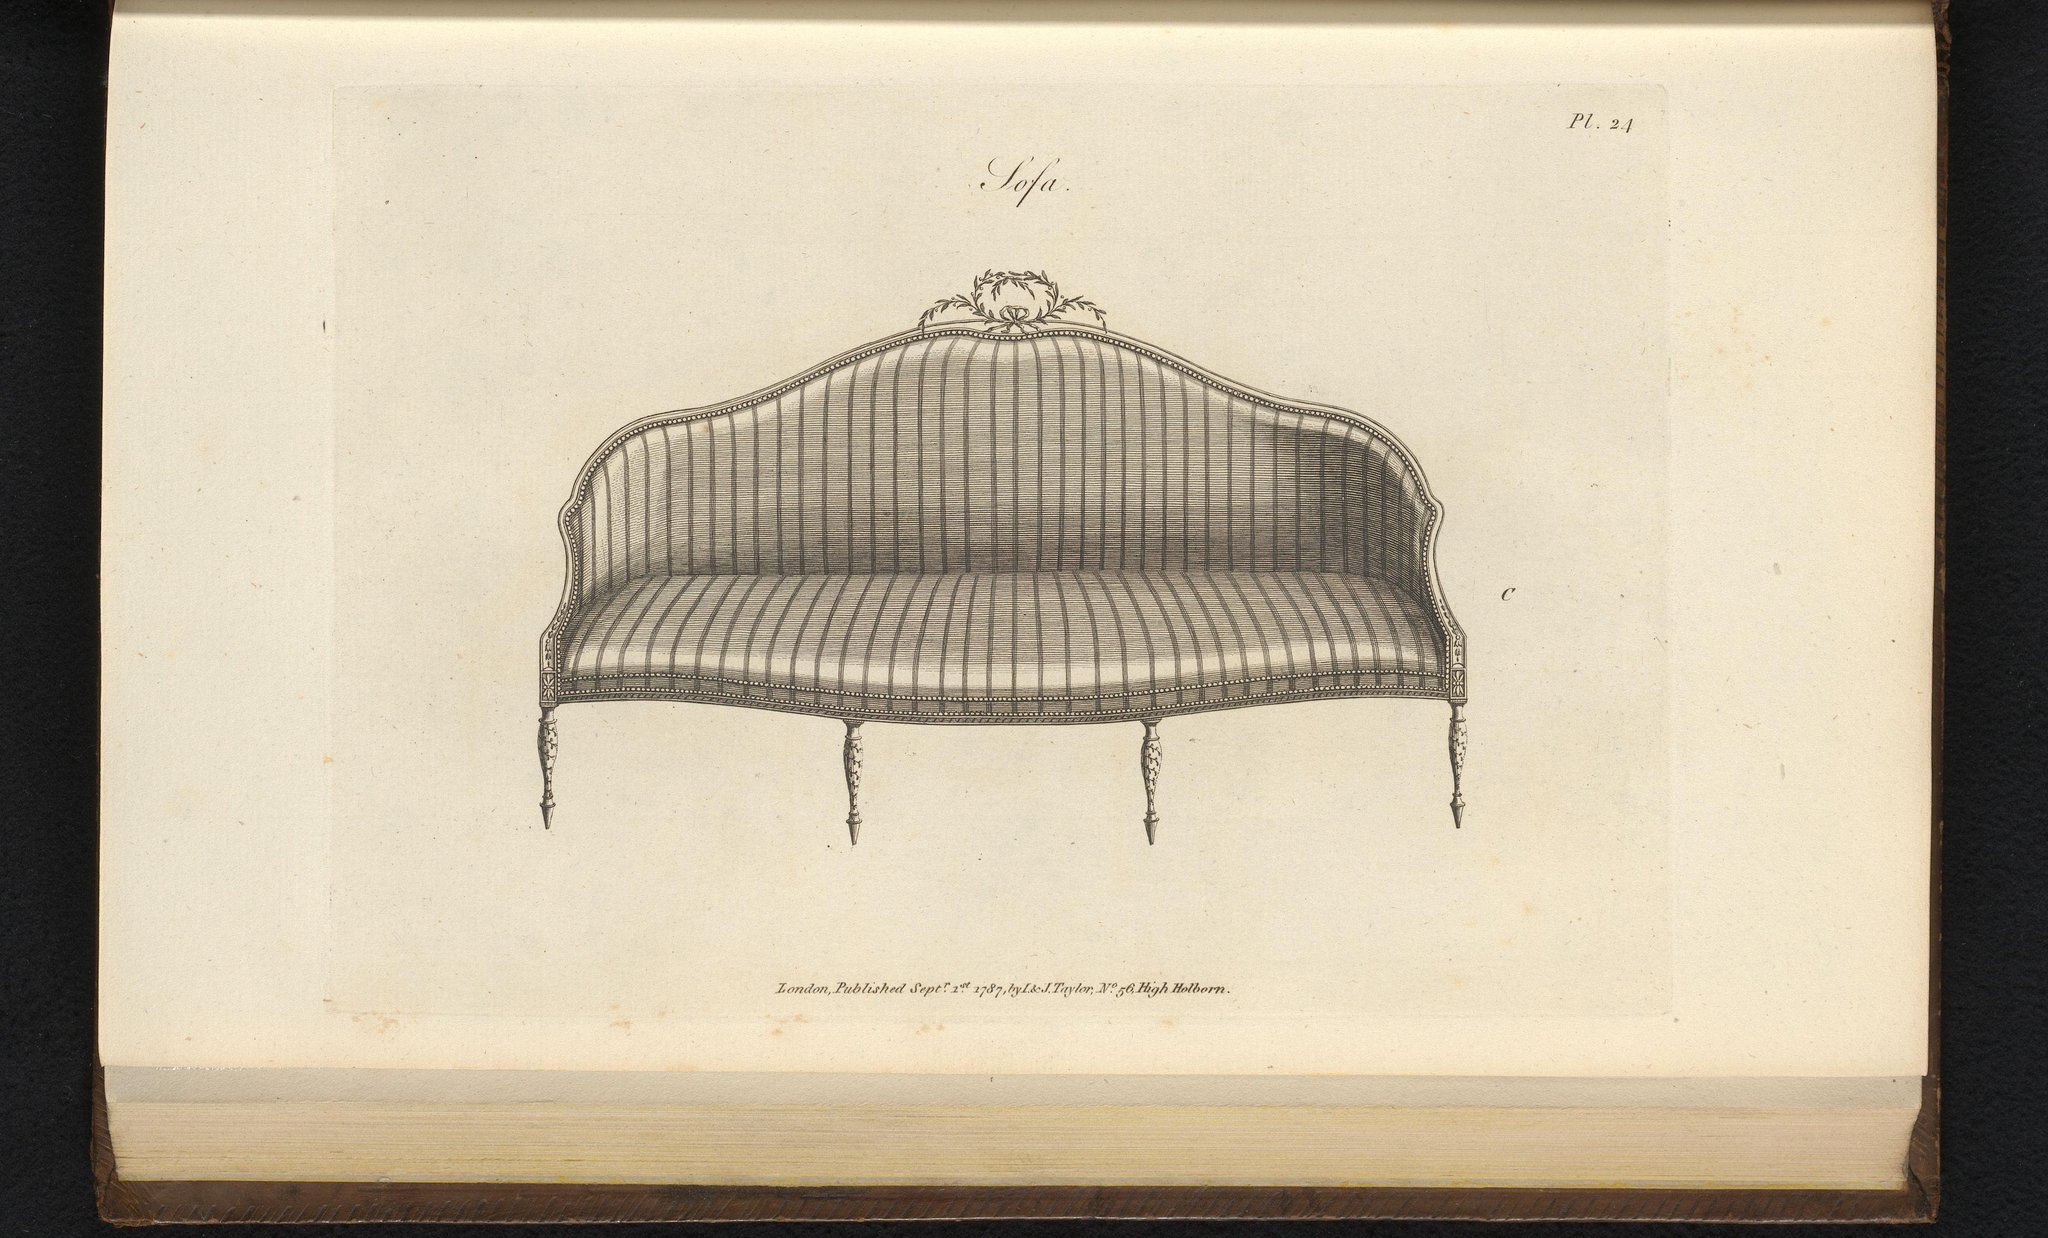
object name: page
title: Sofa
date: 1787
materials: paper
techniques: engraving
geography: holborn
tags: couch, sofa, settee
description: Genummerd: Pl. 24. Bank gemerkt: C. Prent maakt deel uit van een boek.